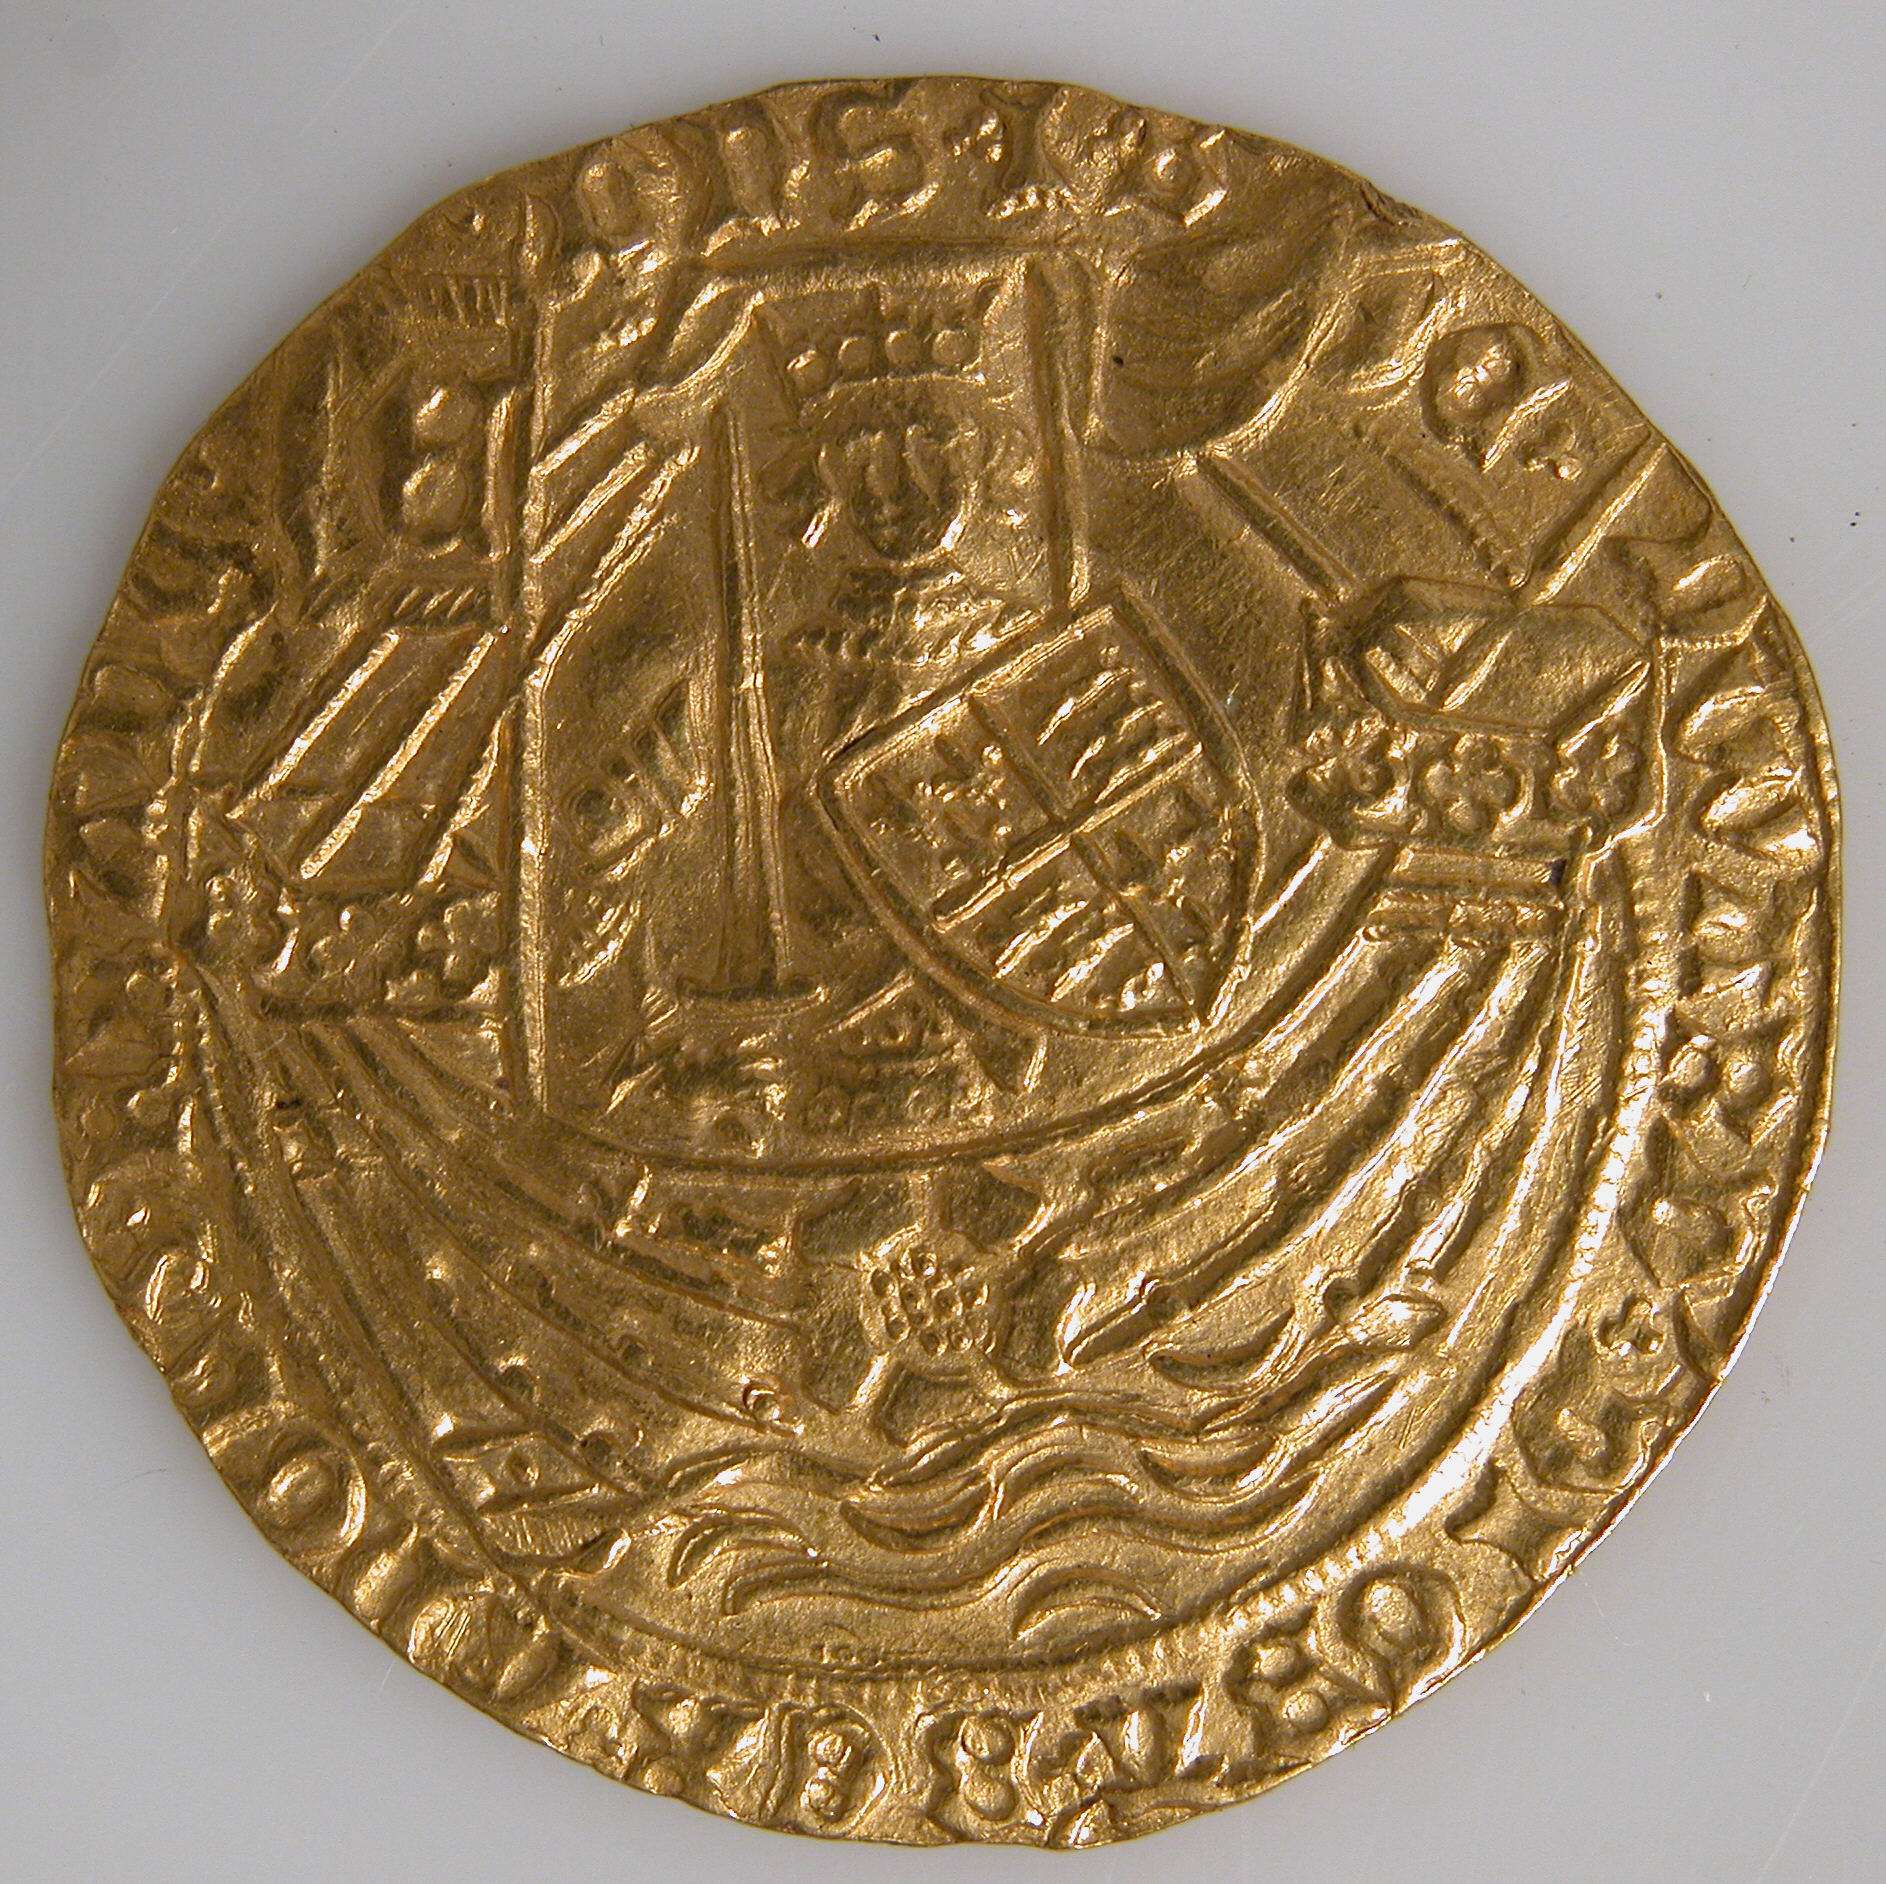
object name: coin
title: Rose Noble of Edward IV (1461-1483)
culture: british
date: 1461-1483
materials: gold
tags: coat of arms